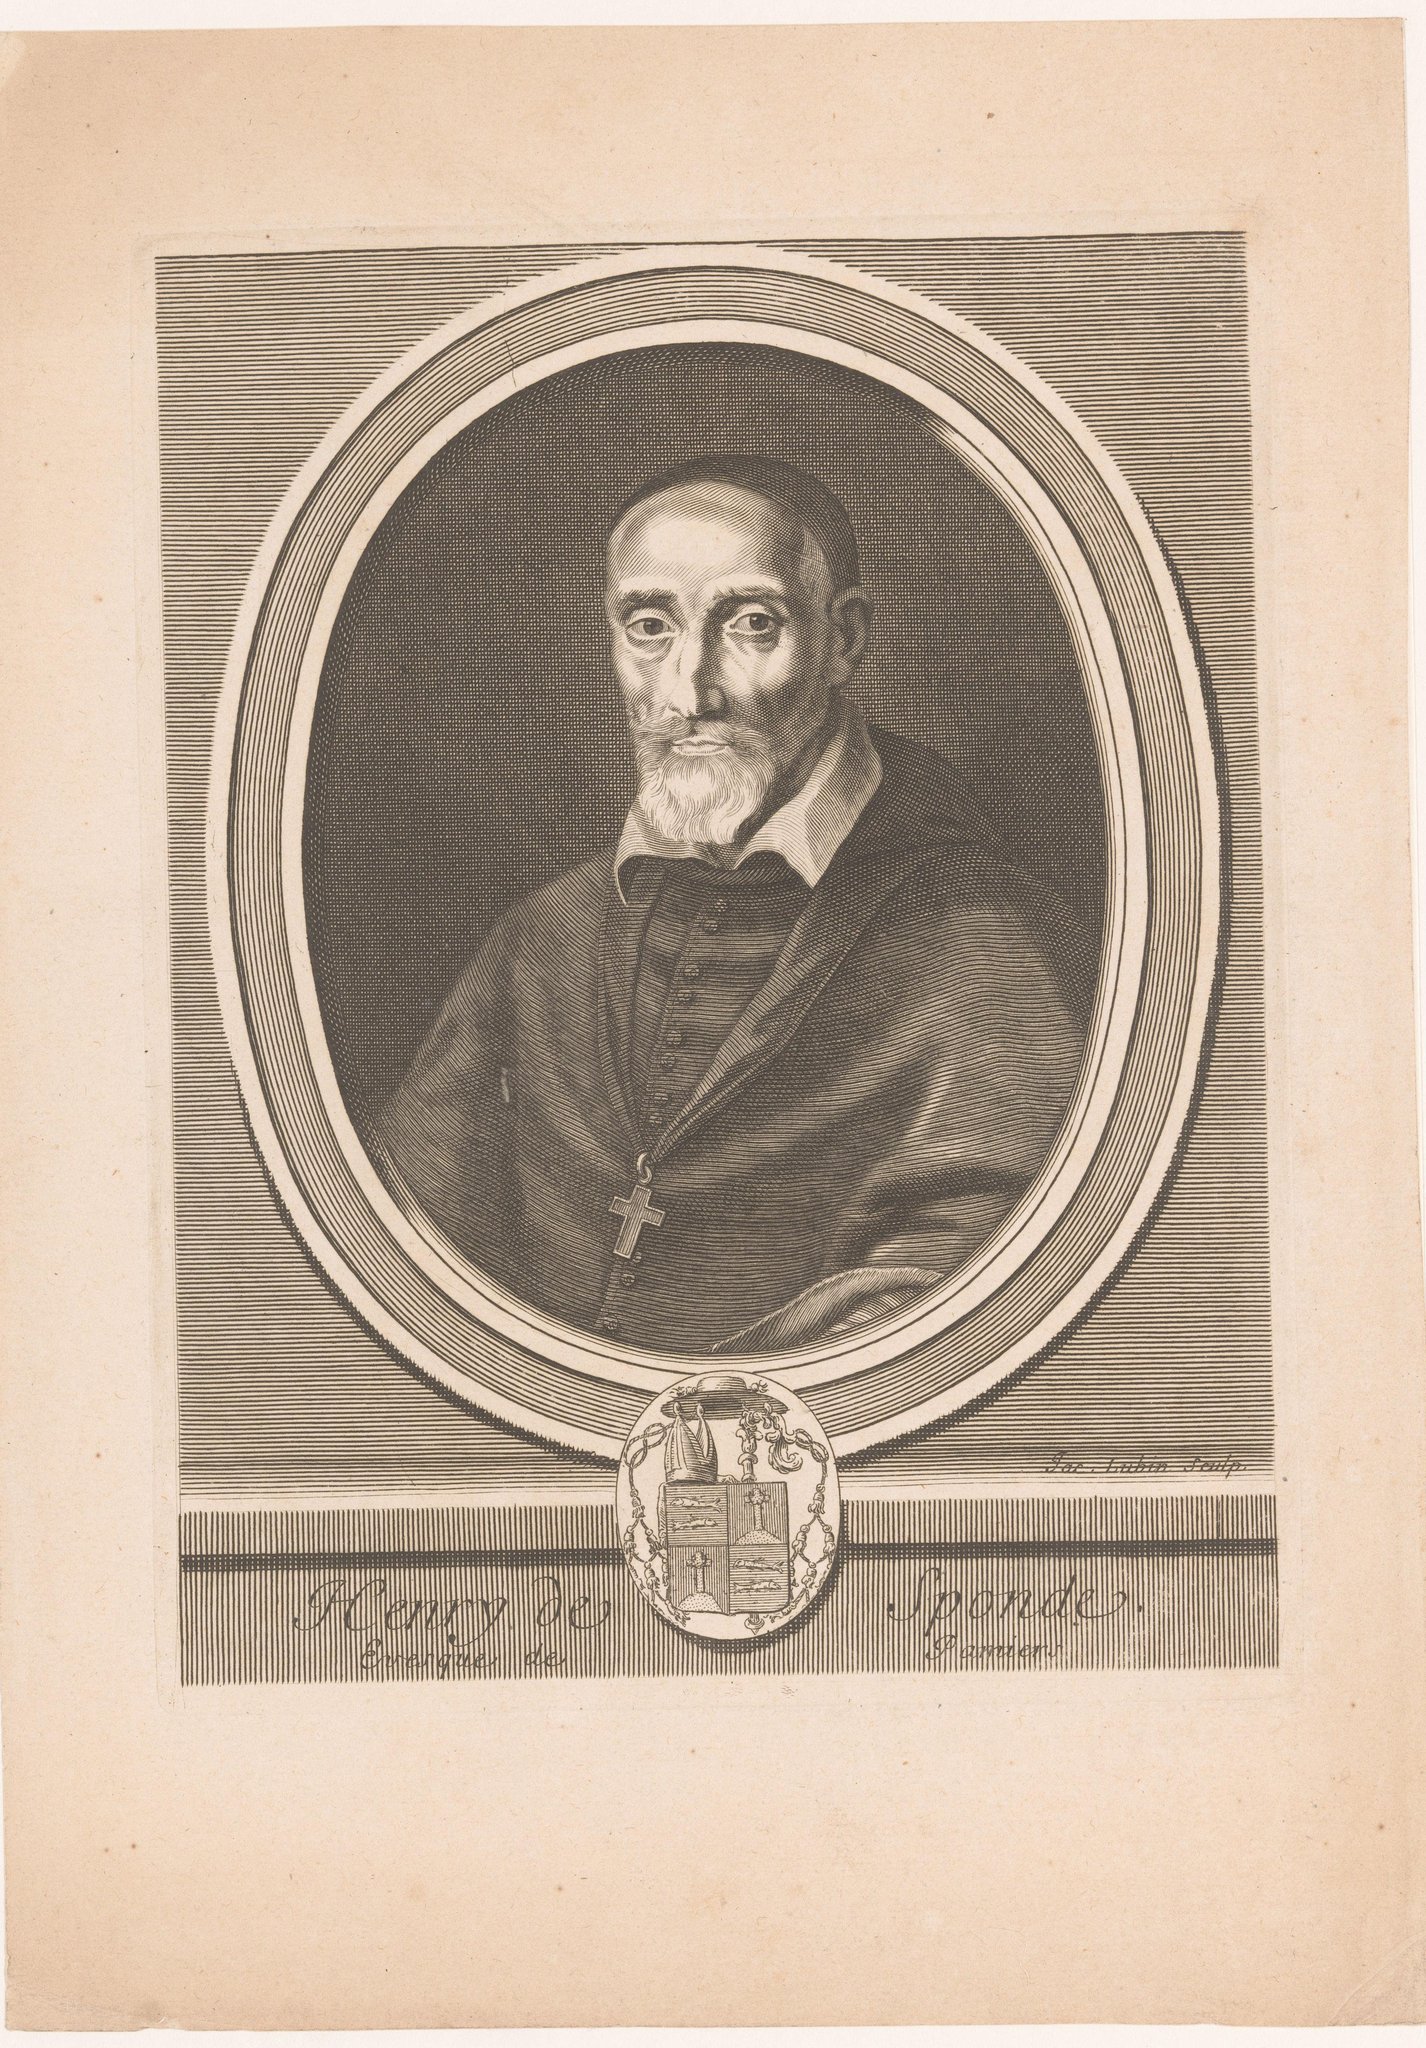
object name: print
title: Portret van Henri Spondanus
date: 1696-1700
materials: paper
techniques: engraving, etching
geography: paris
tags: archbishop, bishop, etc. (roman catholic), historical persons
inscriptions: collector's mark: Lugt 2228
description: Prent uit: Perrault, Charles. Les hommes illustres qui ont paru en France pendant ce siècle. Parijs: Antoine Dezallier, 1696-1700.